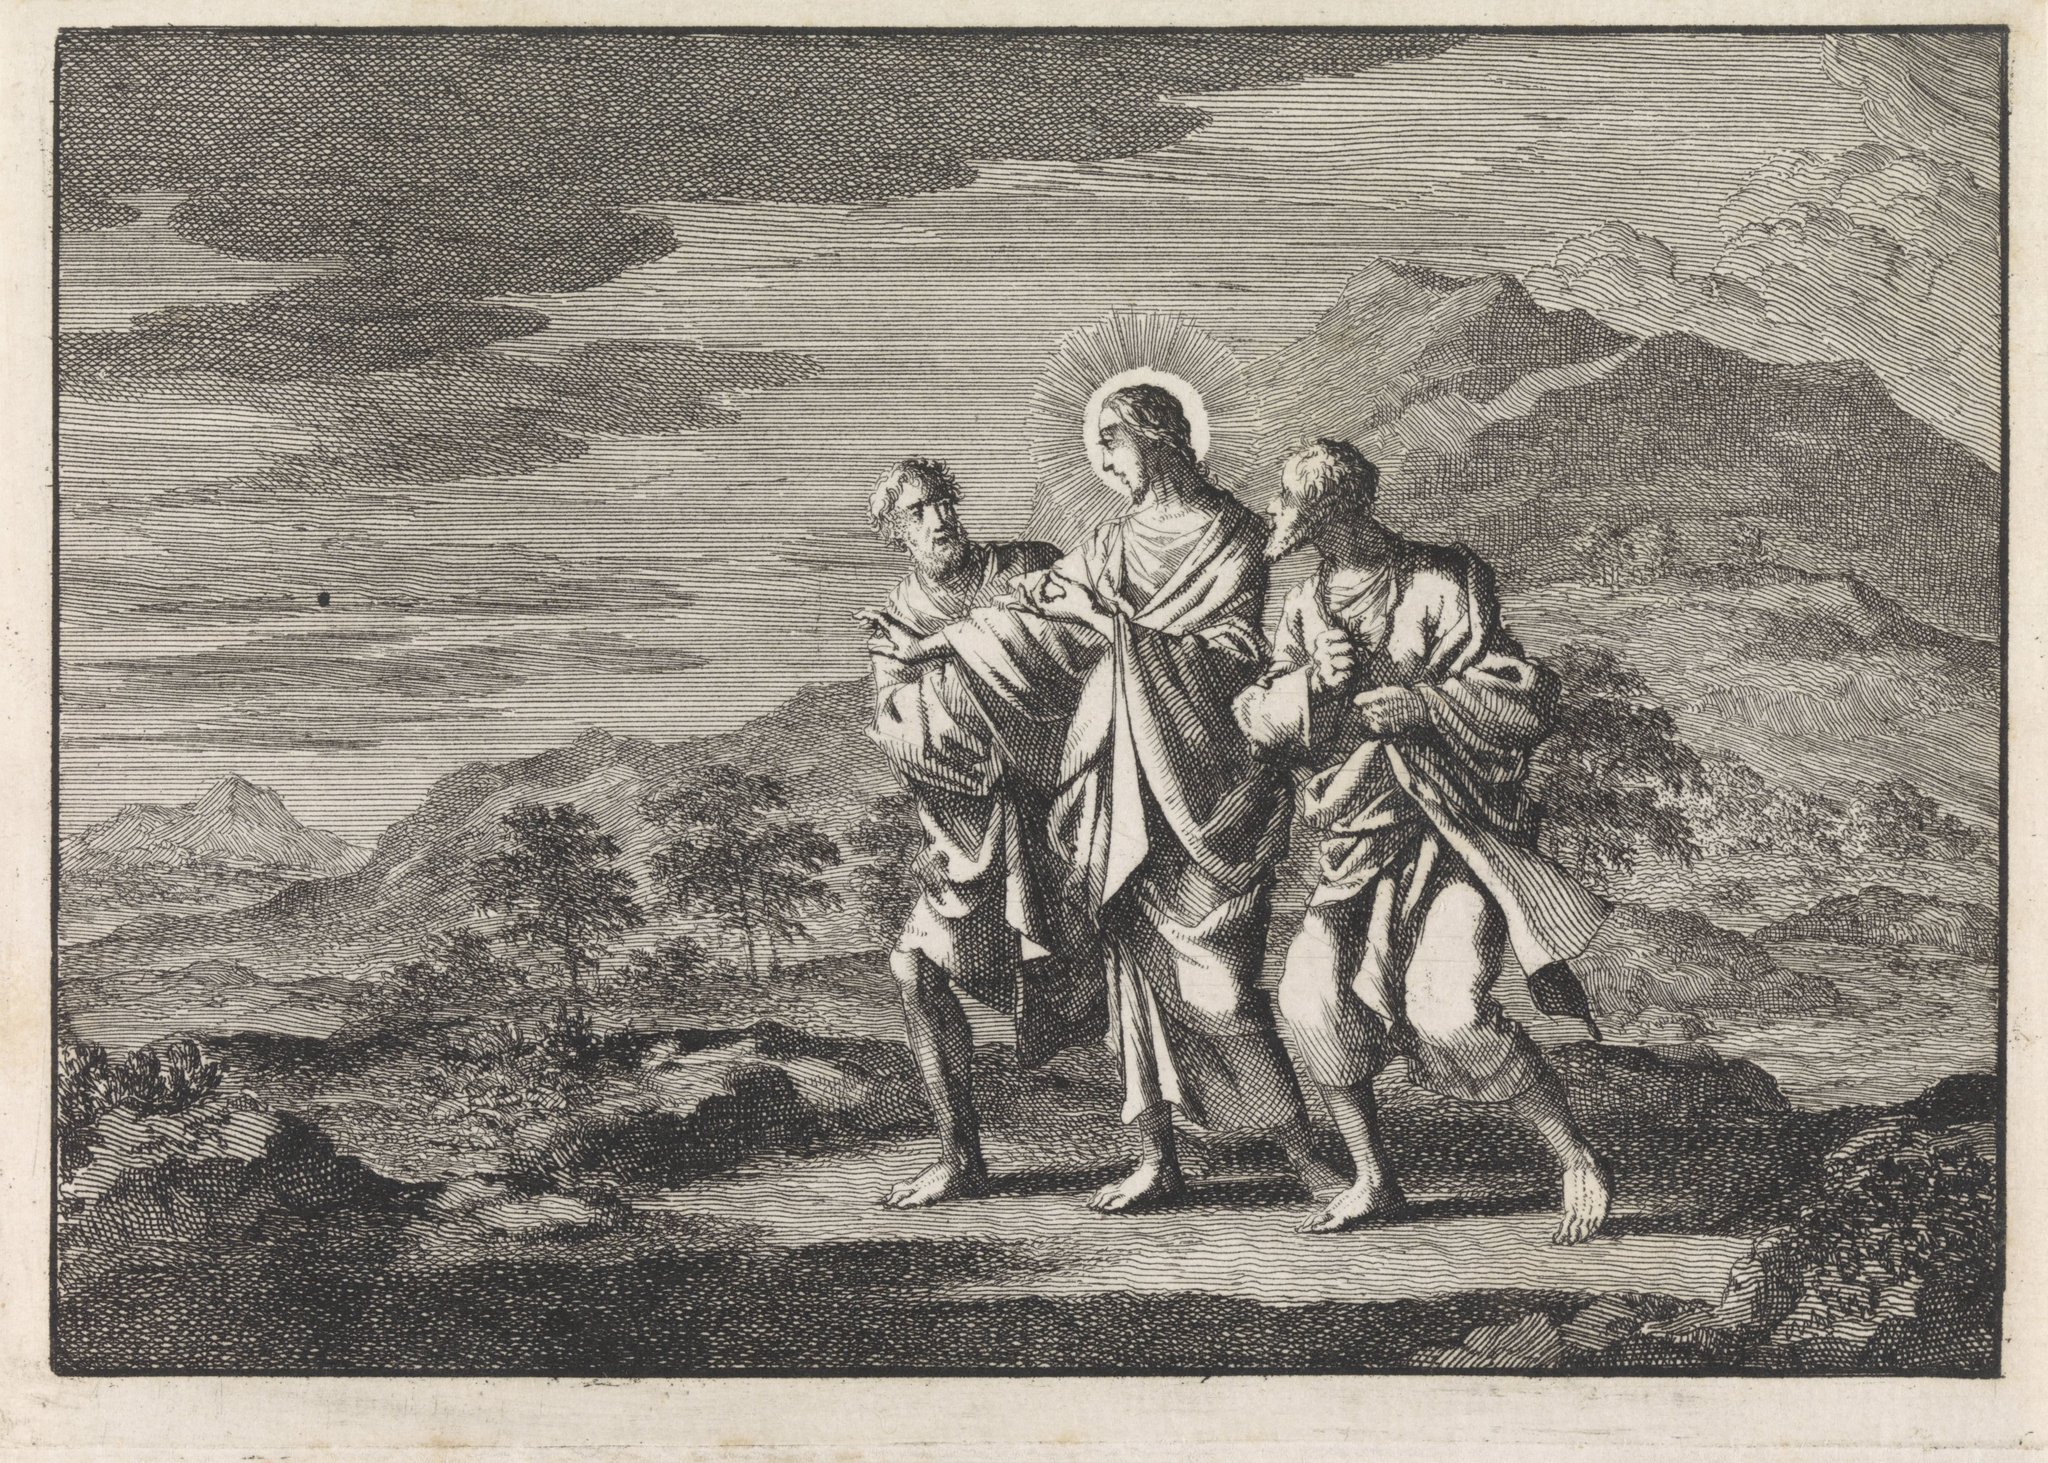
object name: print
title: Emmaüsgangers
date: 1703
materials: paper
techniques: etching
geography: amsterdam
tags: the journey to emmaus: two disciples (cleopas and peter) under way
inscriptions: collector's mark: Lugt 2228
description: Proefdruk van een boekillustratie voor David Martin. Historie des Ouden en Nieuwen Testaments. Amsterdam, Pieter Mortier, 1703. Deel II. De boekillustraties voor de Mortierbijbel hebben verschillende staten en kopieën, waarbij de chronologische volgorde moeilijk te achterhalen valt. Als boekillustraties werden ze bovendien herhaaldelijk opnieuw gebruikt voor andere boekwerken.